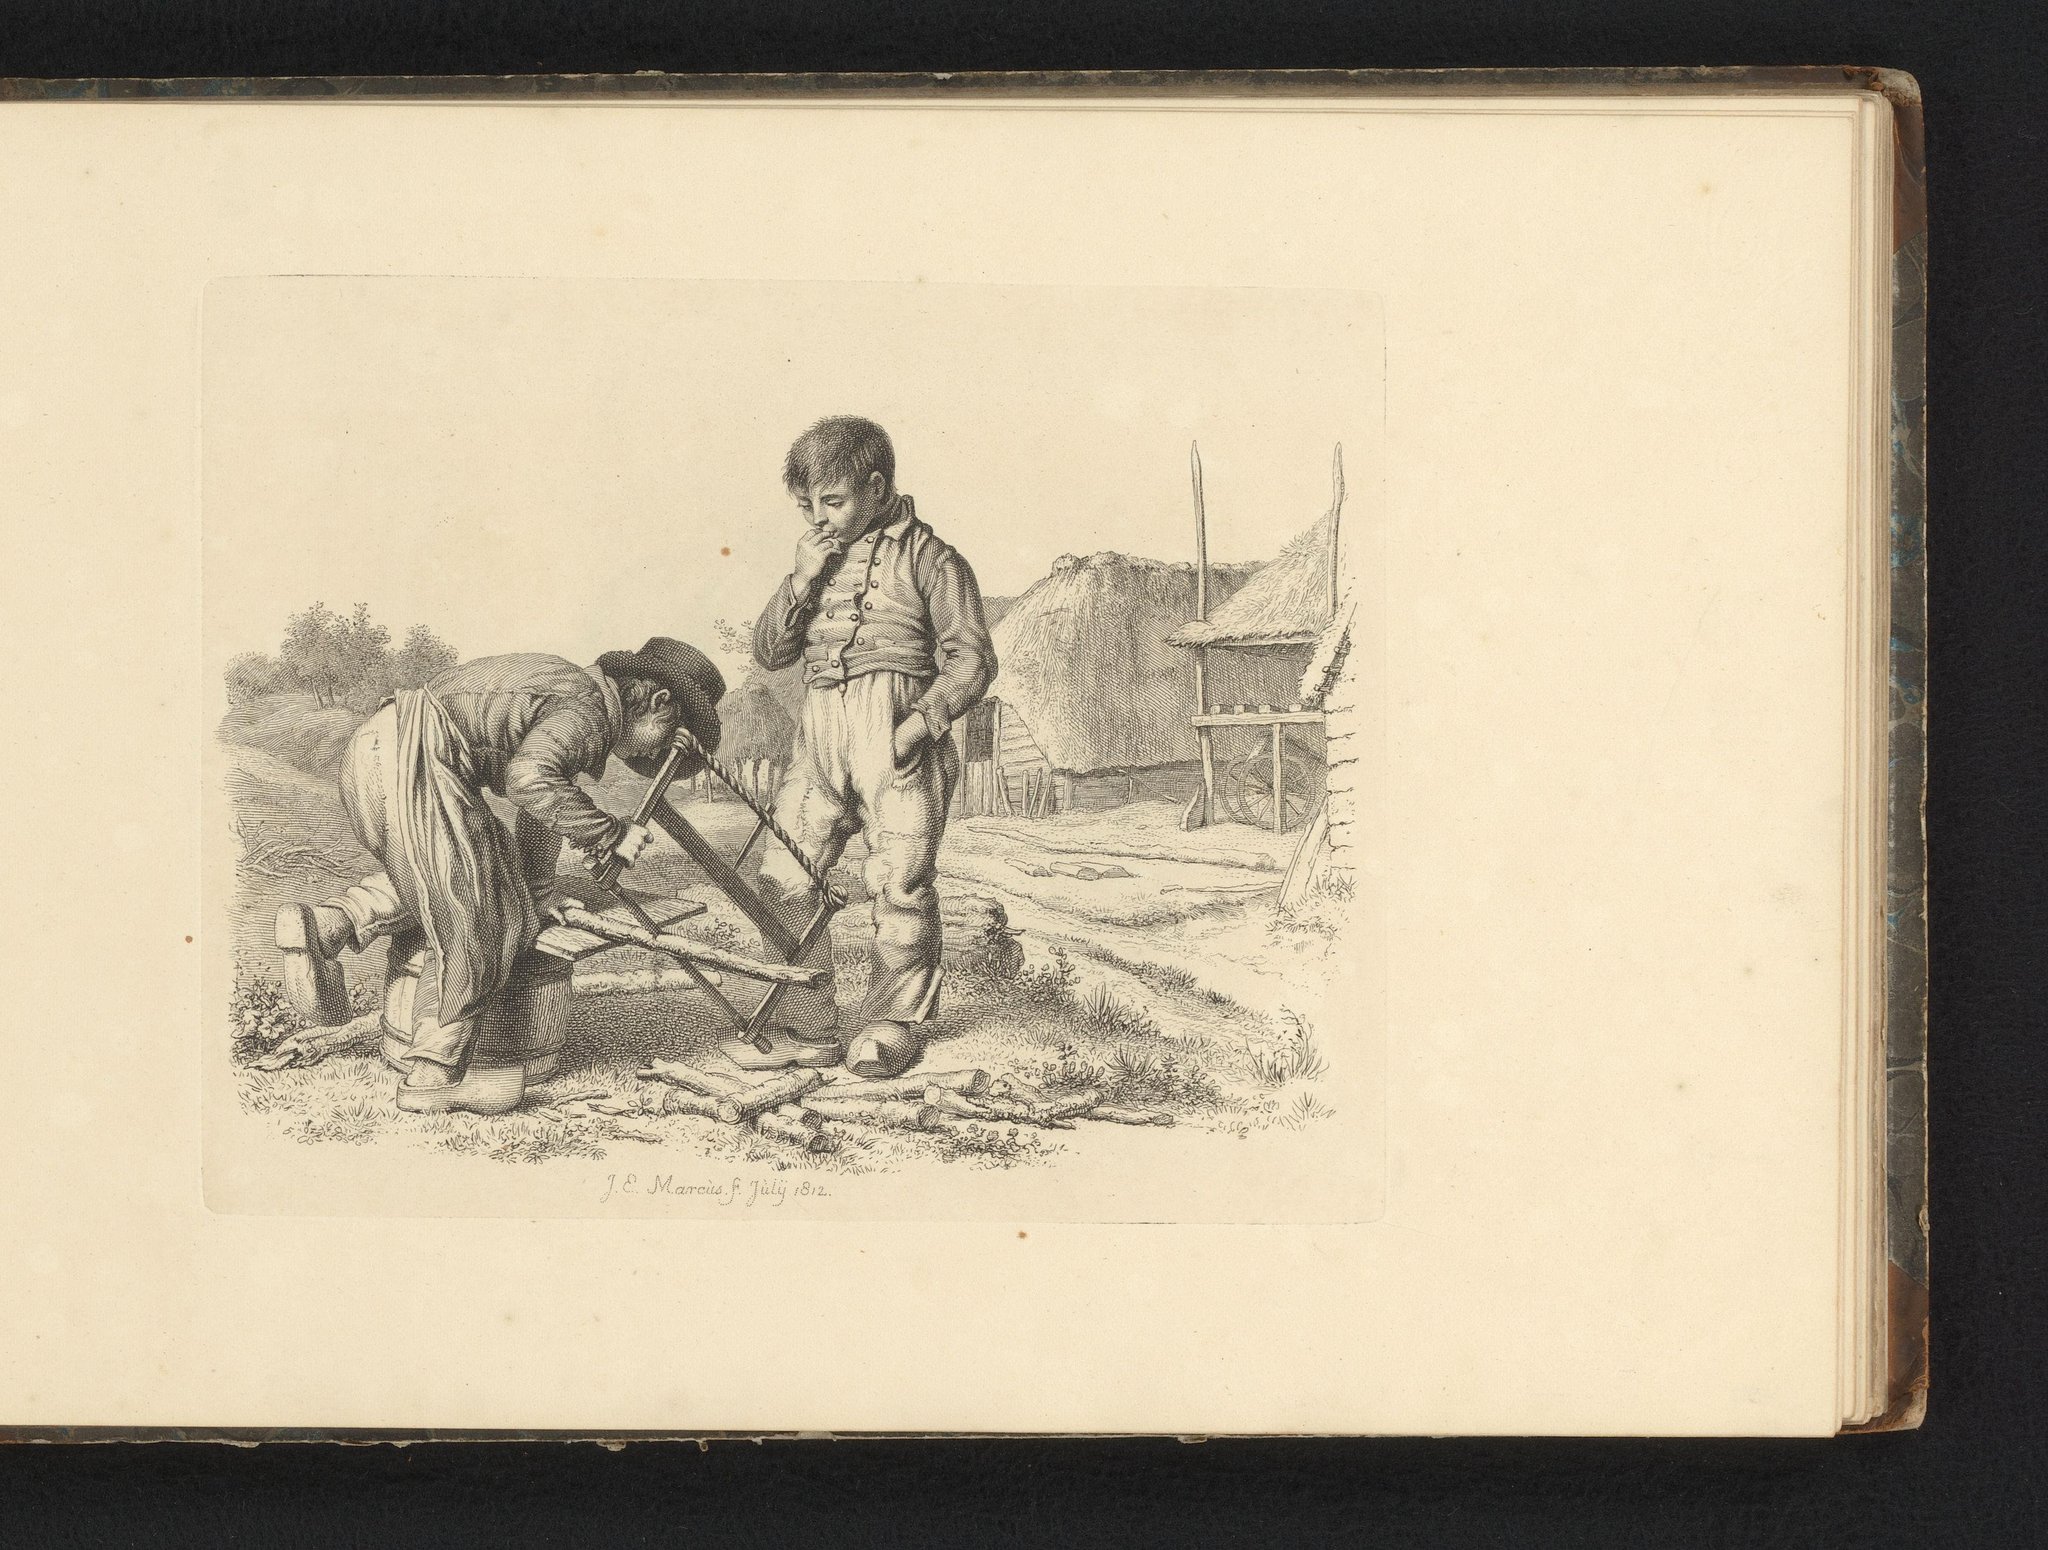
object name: print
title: Twee jongens met een zaag bij een boerderij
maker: jacob ernst marcus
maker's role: draughtsman, print maker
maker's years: 1774-1826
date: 1807-1812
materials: paper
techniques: etching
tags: farm or solitary house in landscape, tools, aids, implements ~ crafts and industries: saw, farm (building)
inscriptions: date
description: Deze prent maakt deel uit van een album.